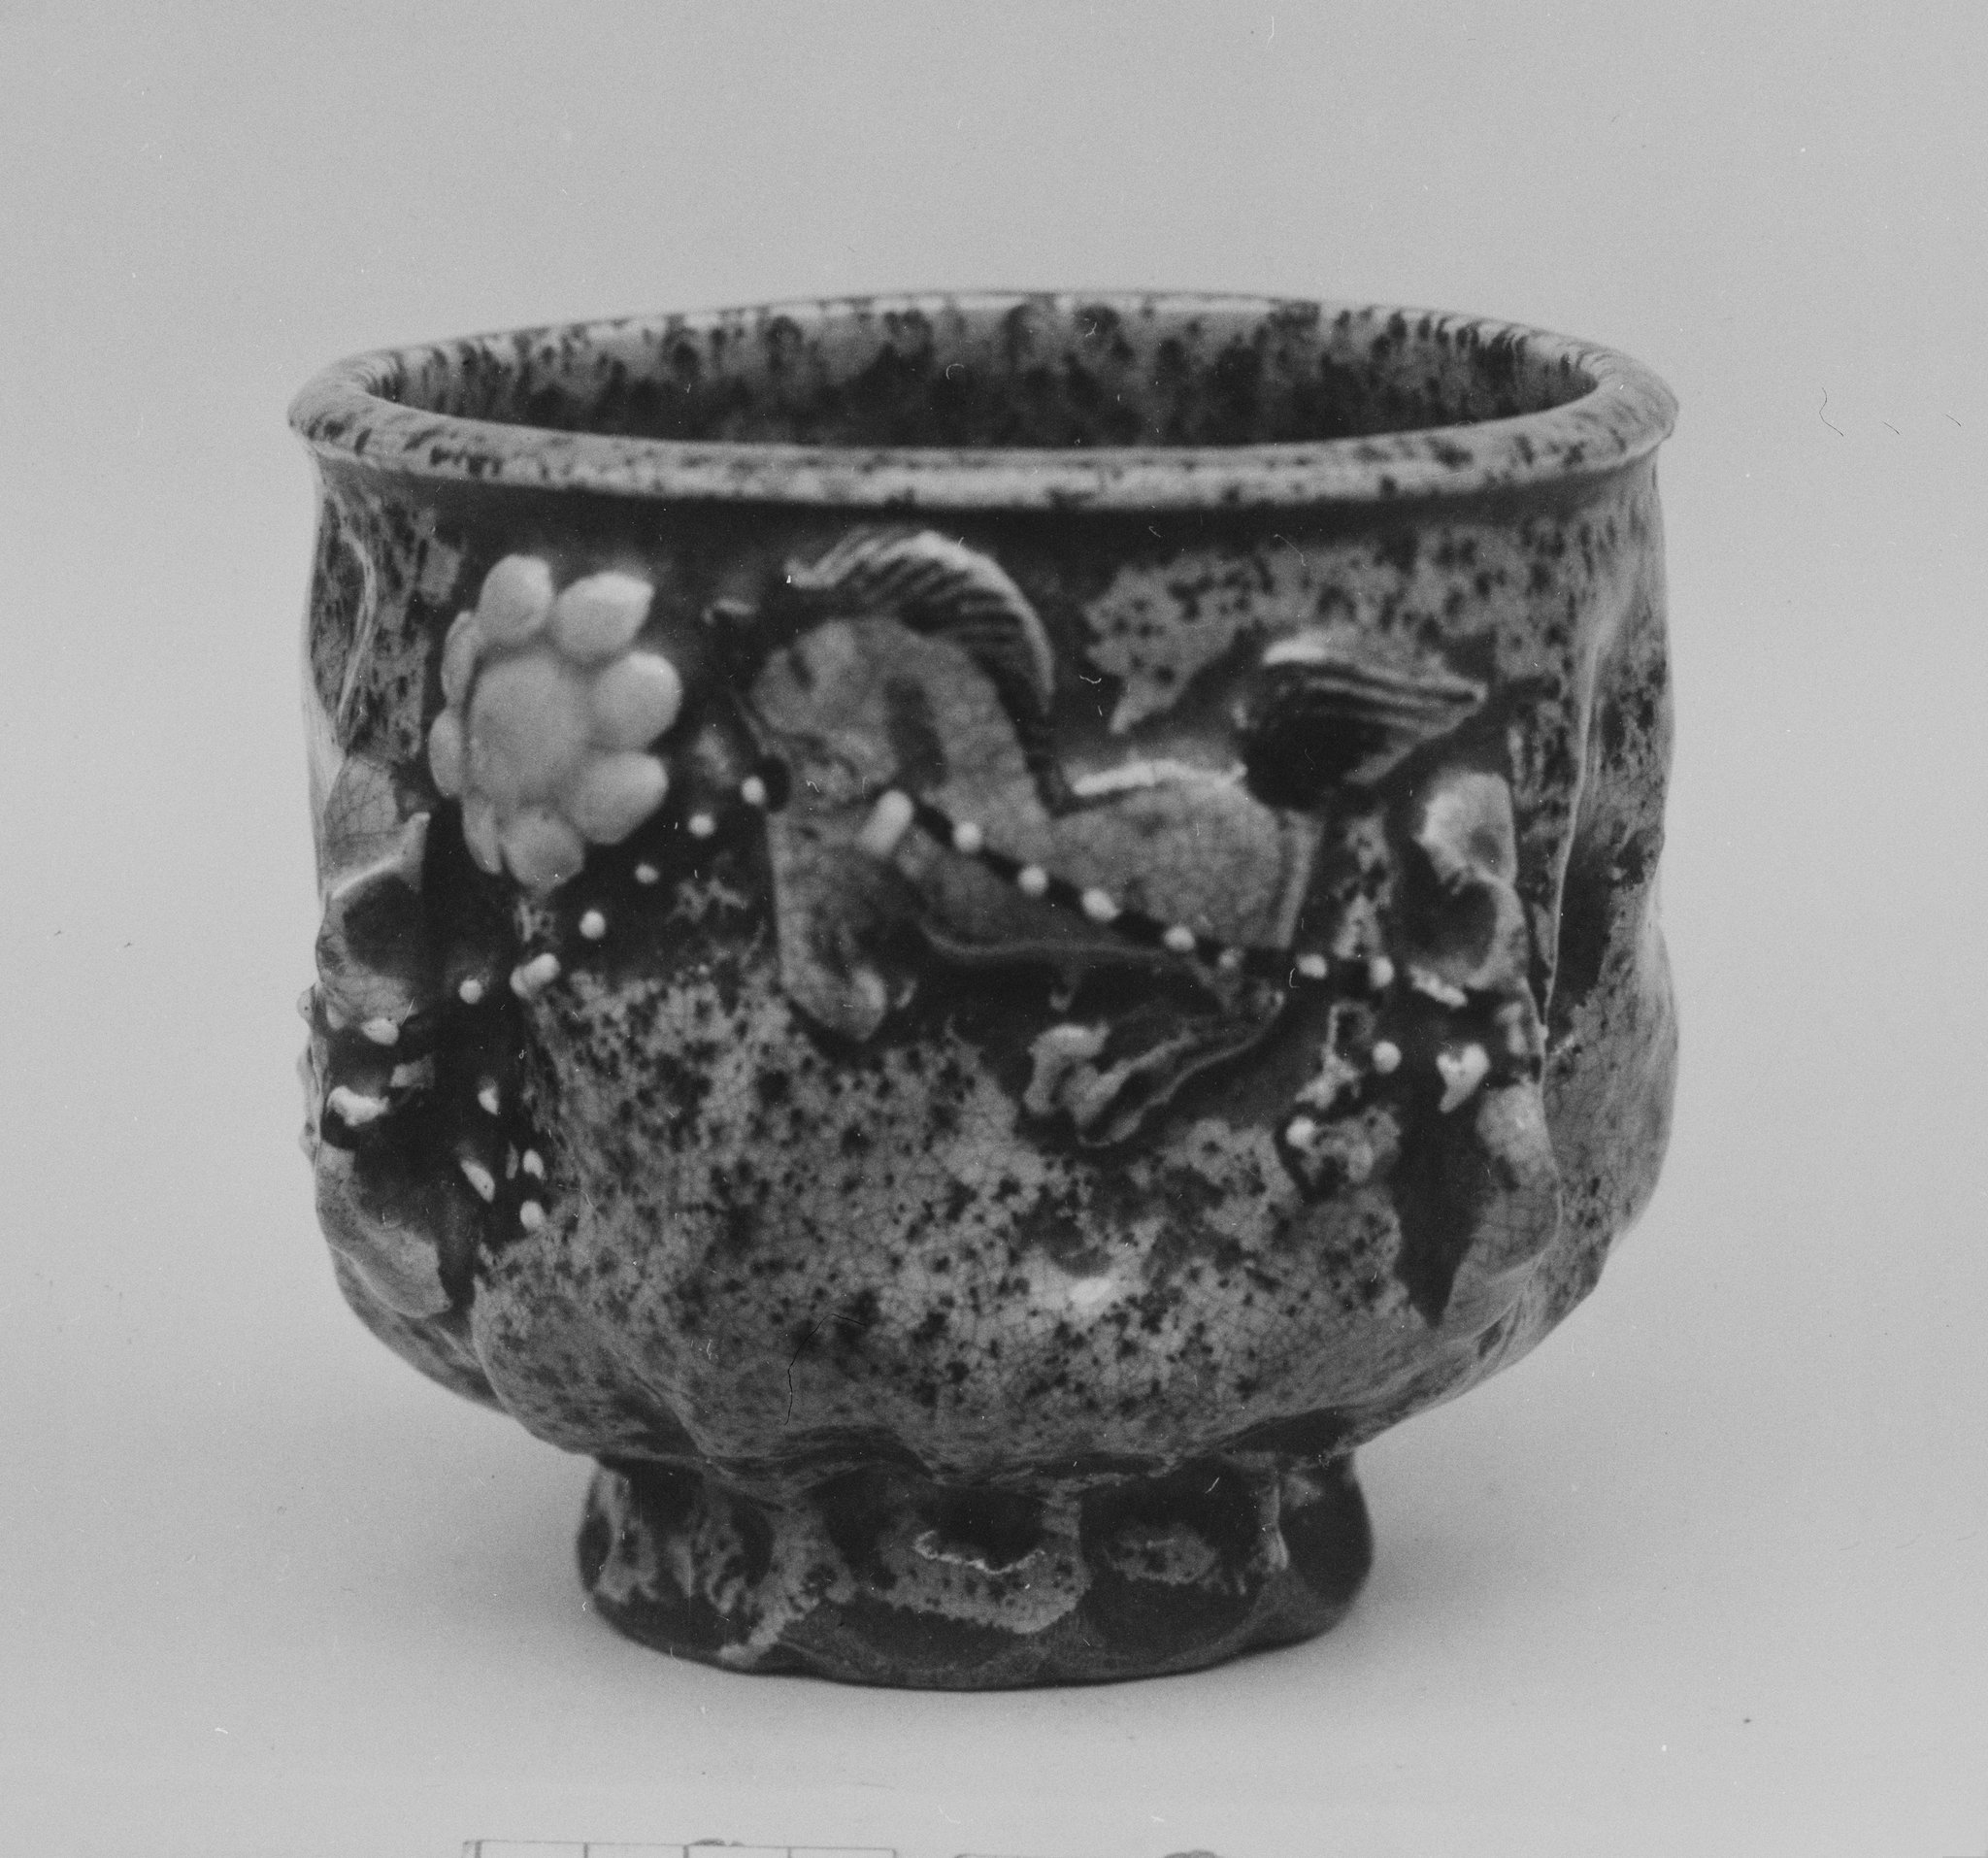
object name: cup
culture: japanese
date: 1840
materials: glaze, pottery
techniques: relief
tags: horses,flowers